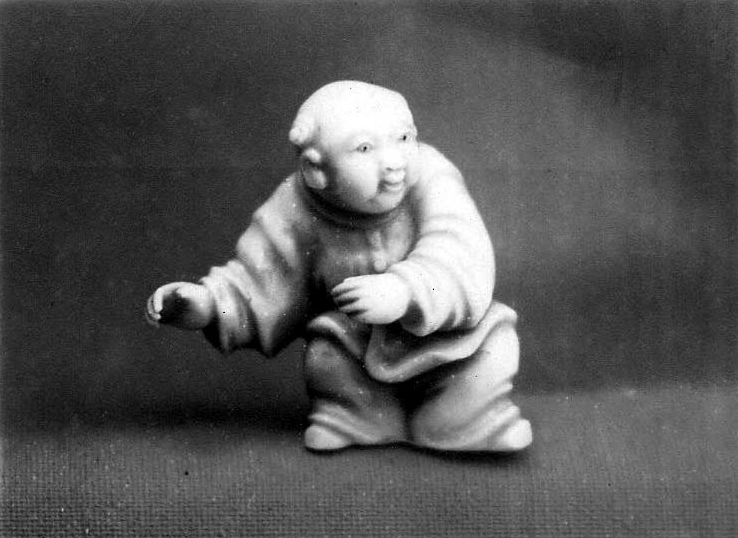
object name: ornament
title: Boy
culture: japanese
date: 1800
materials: porcelain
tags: boys